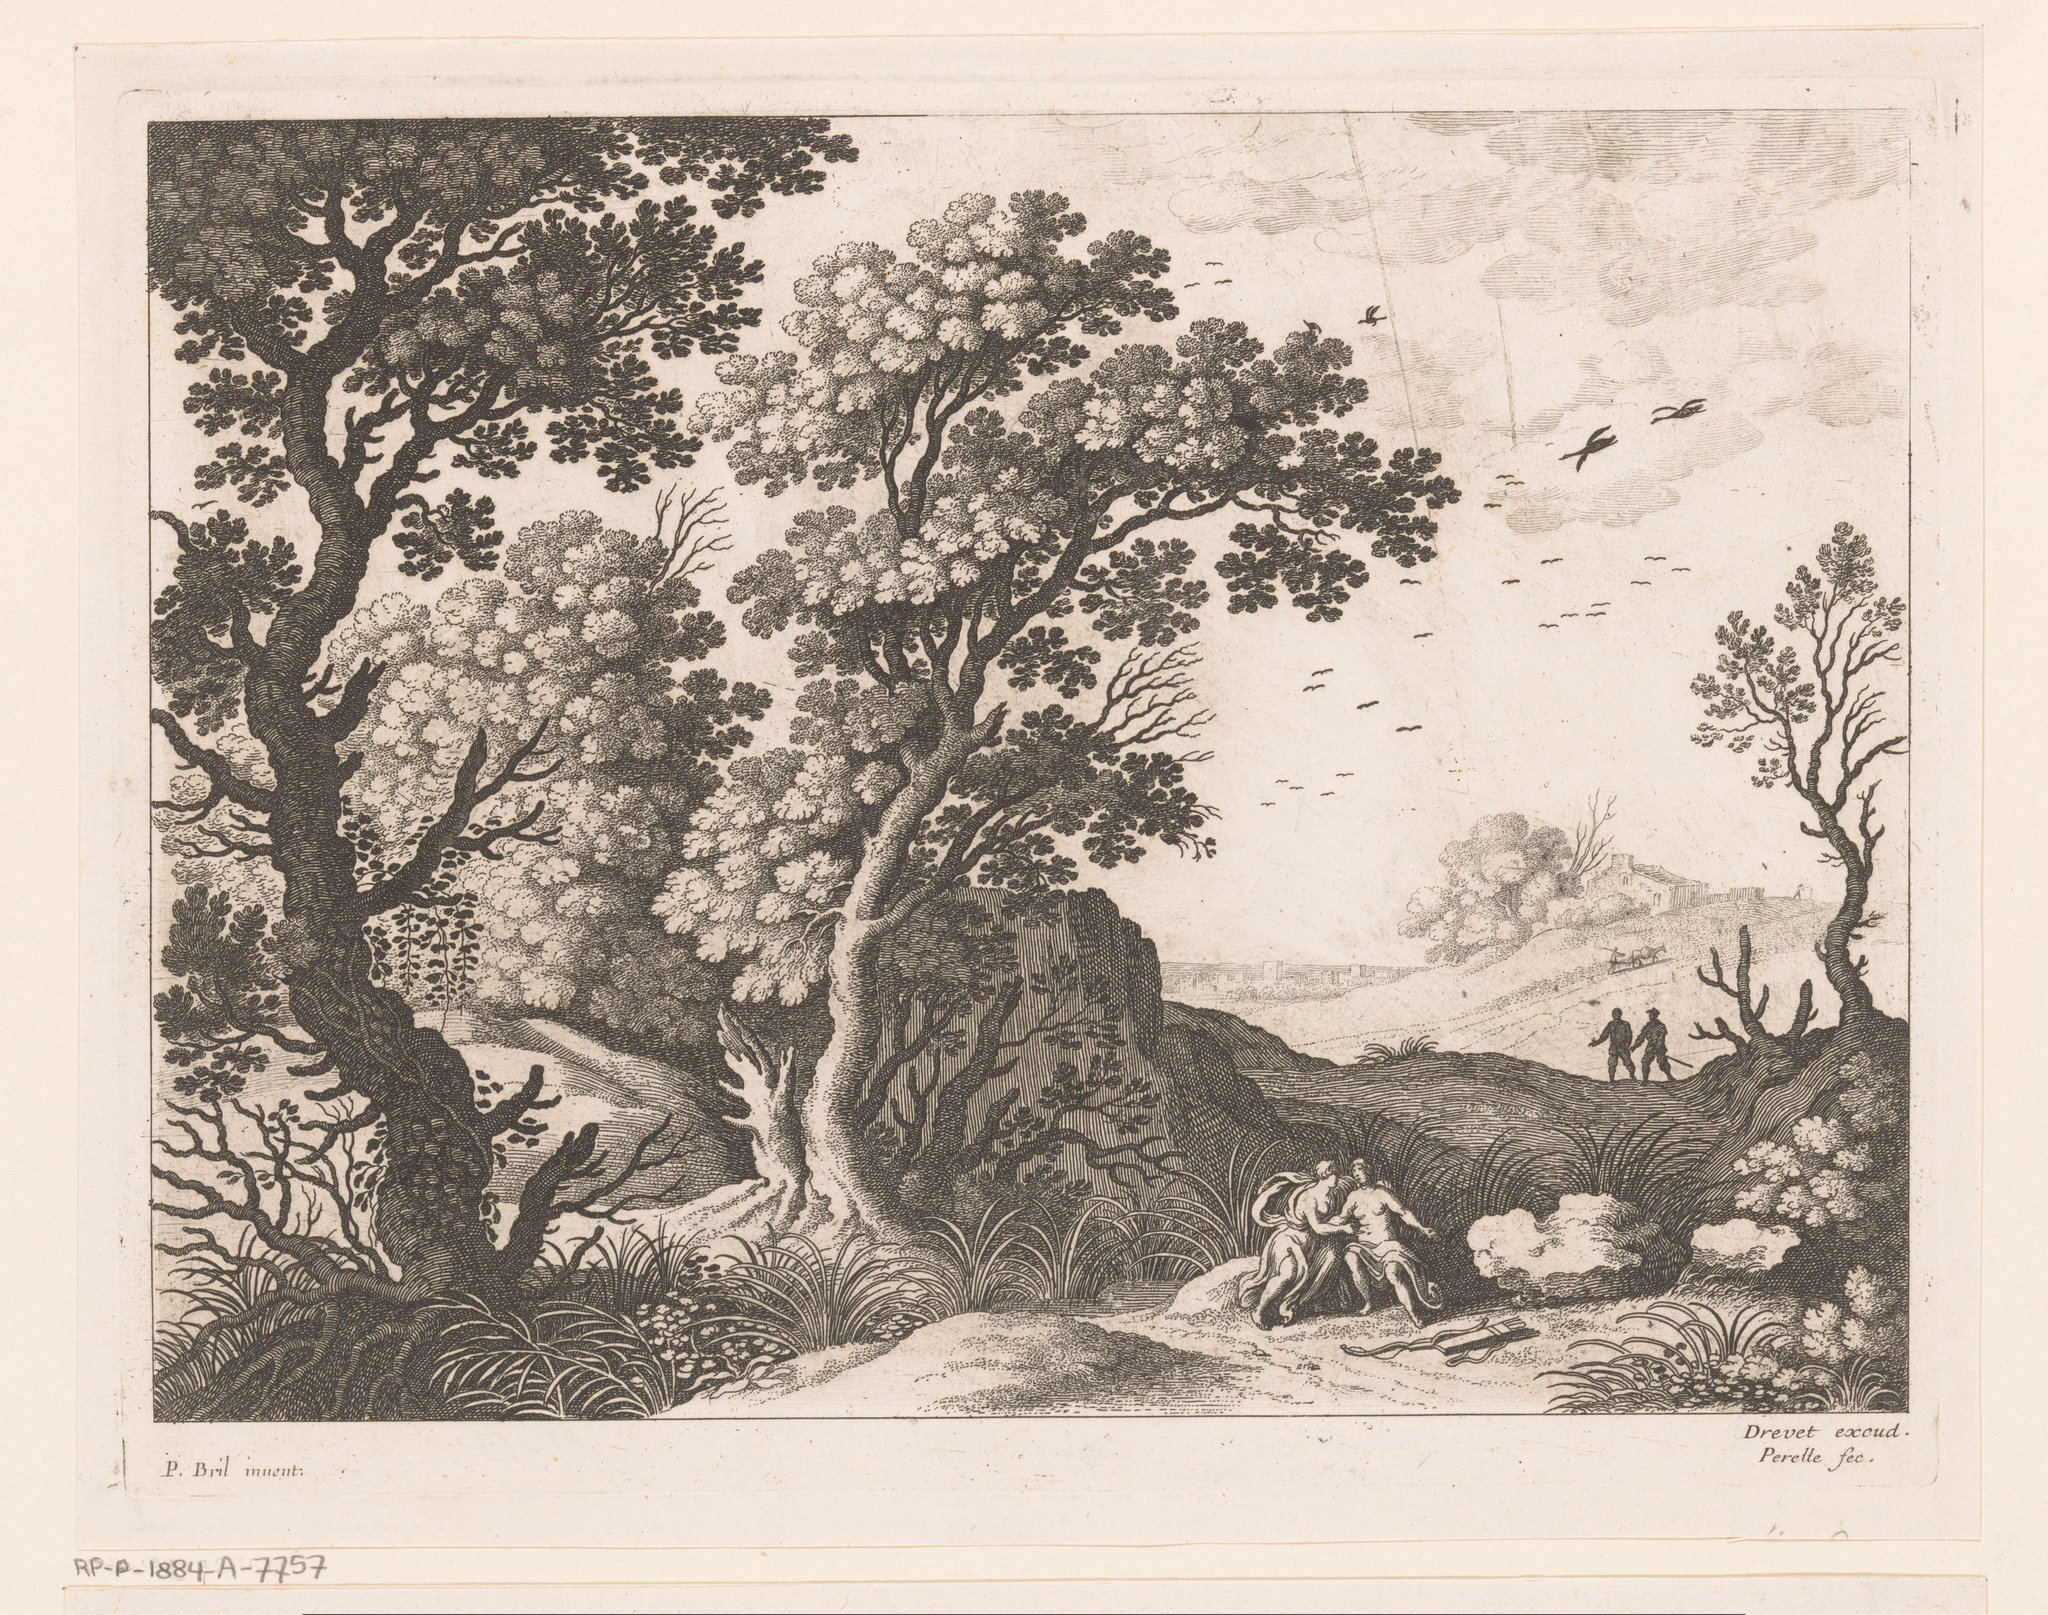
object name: print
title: Landschap met Diana en een nimf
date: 1673-1695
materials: paper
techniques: engraving, etching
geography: paris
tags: companions, nymphs of diana; 'ninfe di diana' (ripa), (story of) diana (artemis), landscapes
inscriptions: collector's mark: Lugt 2228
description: Prenten met het signatuur 'Perelle' kunnen zowel door vader Gabriel als door zonen Nicolas en Adam gemaakt zijn.